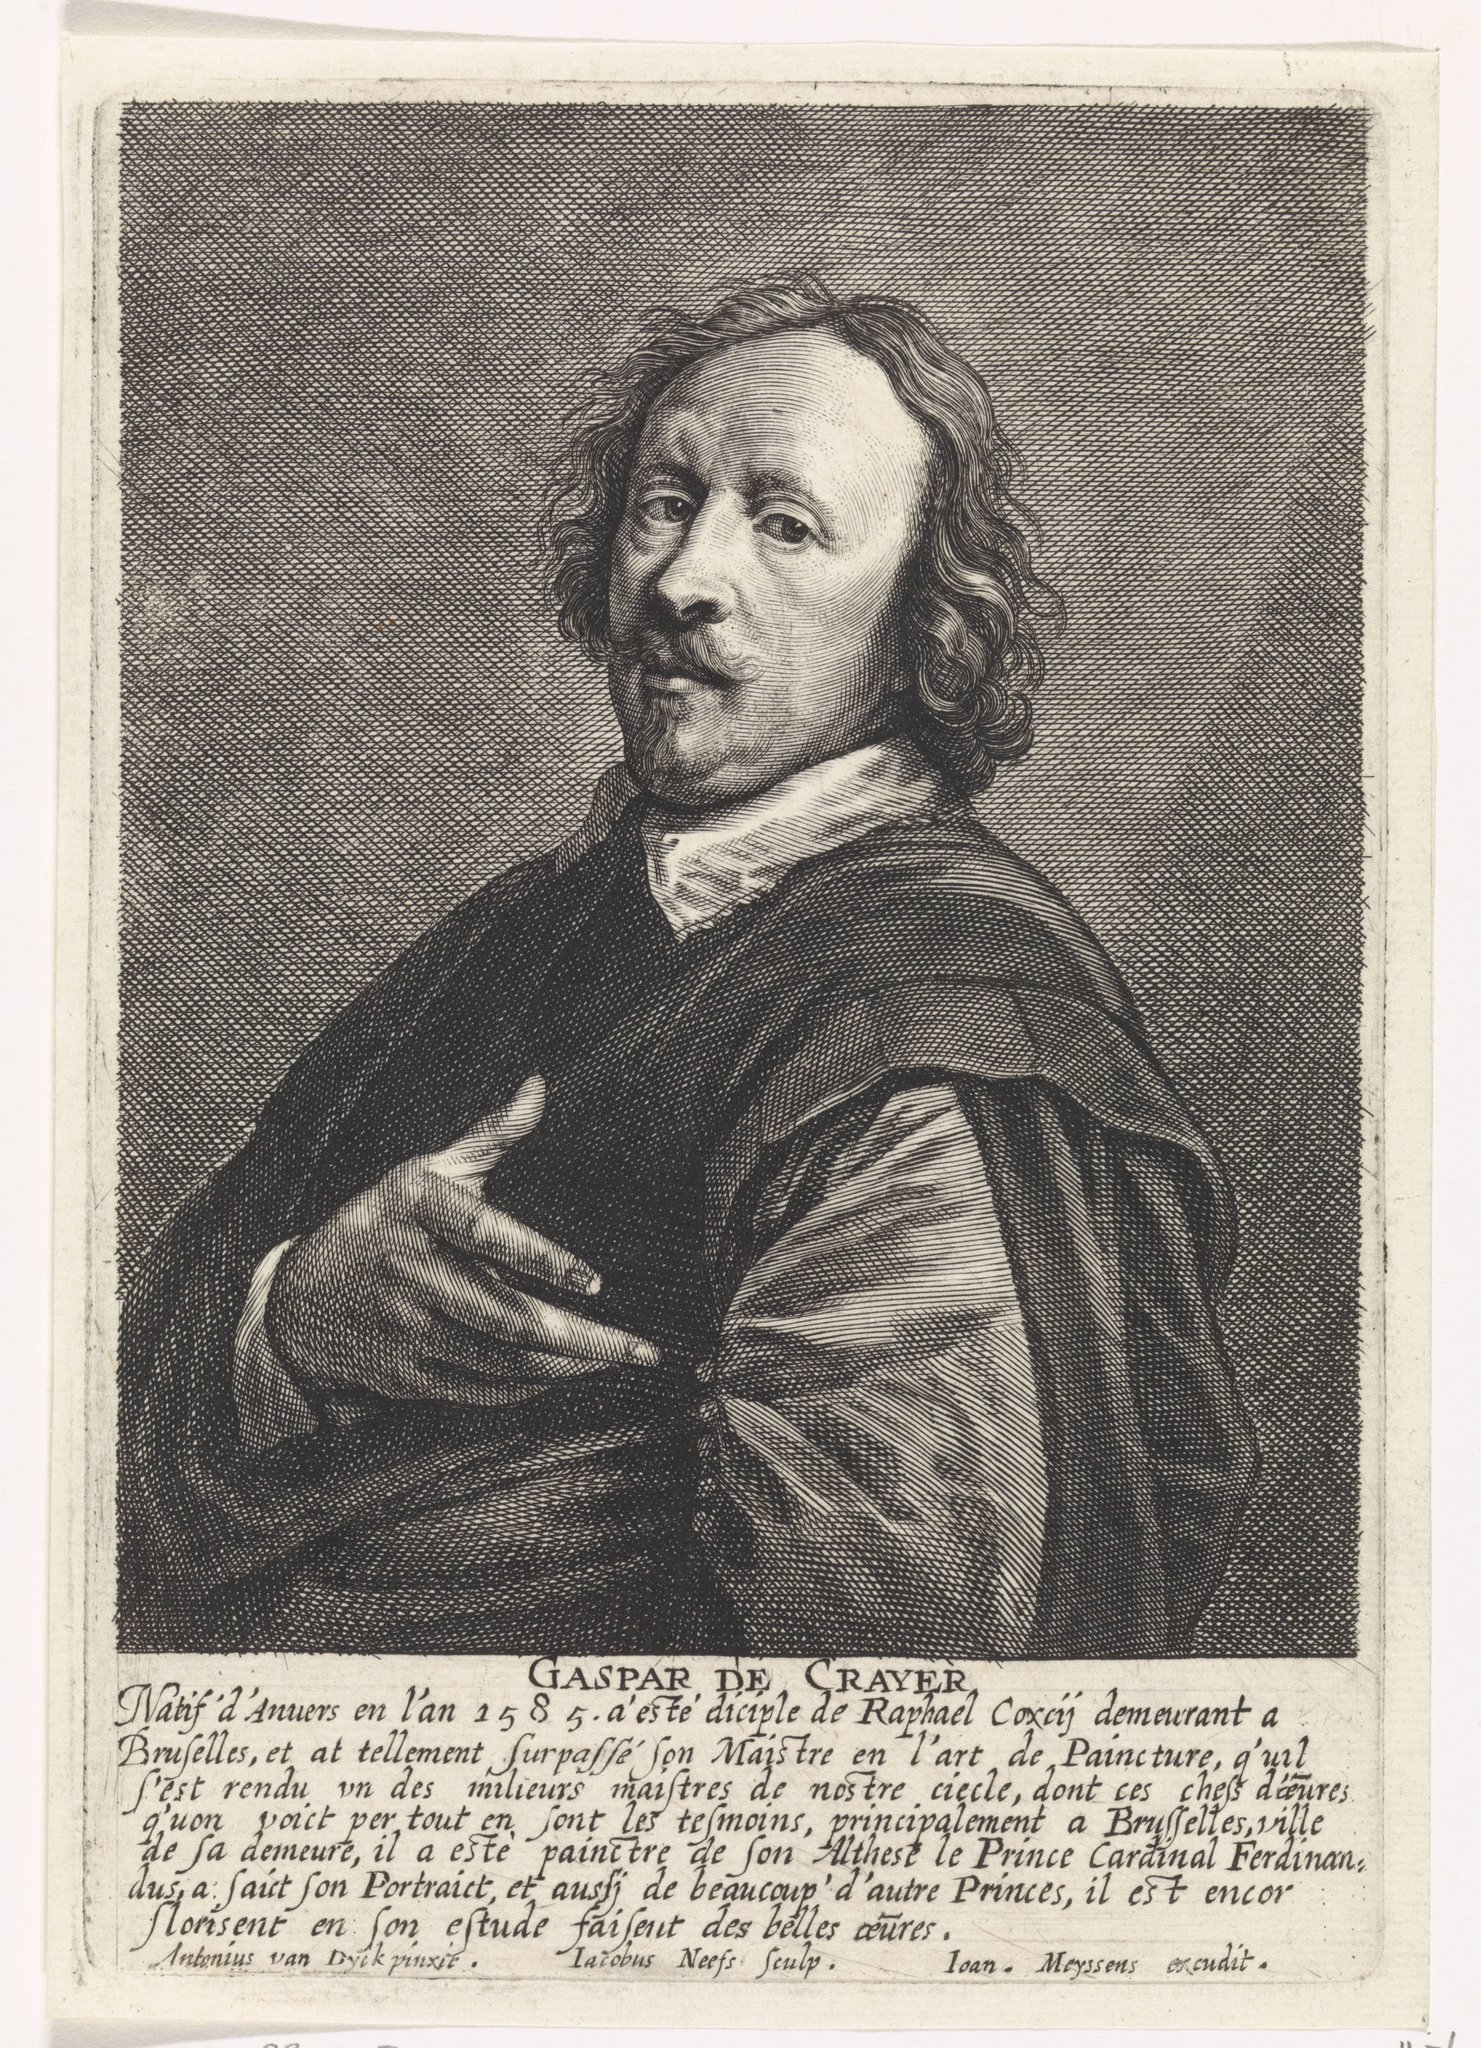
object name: print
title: Portret van Gaspar de Crayer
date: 1620-1680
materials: paper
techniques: engraving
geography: antwerp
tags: antwerp, ghent, print maker, draughtsman, gaspar de crayer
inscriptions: collector's mark: Lugt 2228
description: Gaspar de Crayer, portretschilder te Antwerpen, met zijn rechterhand voor de borst. Portret ten halven lijve naar links. Onderaan in de marge een zevenregelige tekst in het Frans.